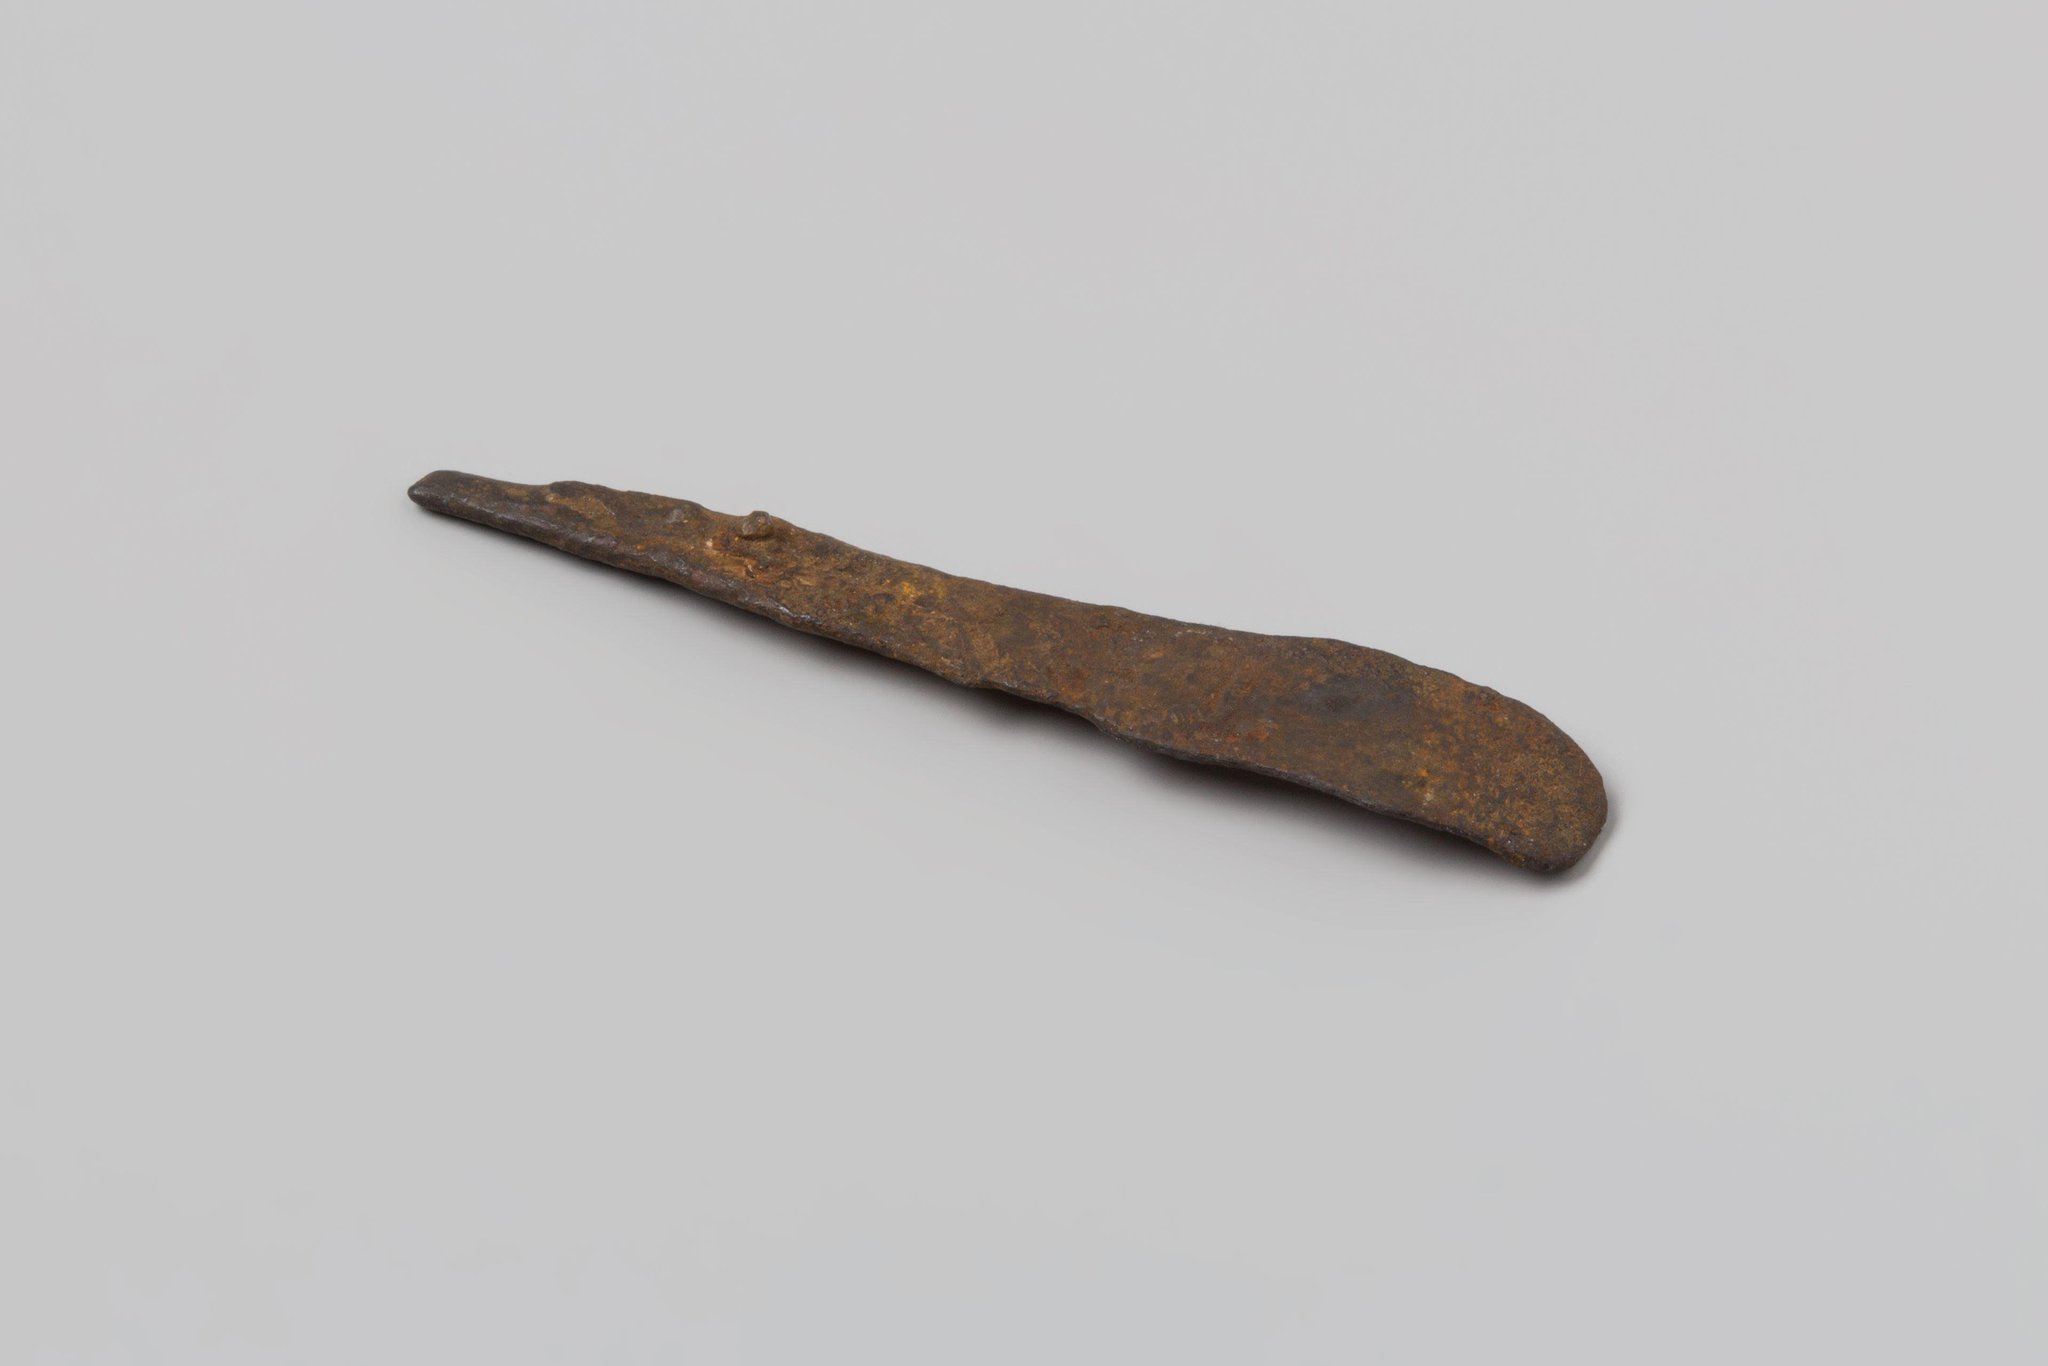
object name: spoon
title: Steel van vork of lepel uit het wrak van de Oost-Indiëvaarder Hollandia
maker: Anonymous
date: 1700-1743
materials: silver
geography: netherlands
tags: verenigde oostindische compagnie, hollandia (schip), annet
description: Cutlery, fragment: stem of fork or spoon; fragm, end, eroded, sim. NG 1980-27H1220.